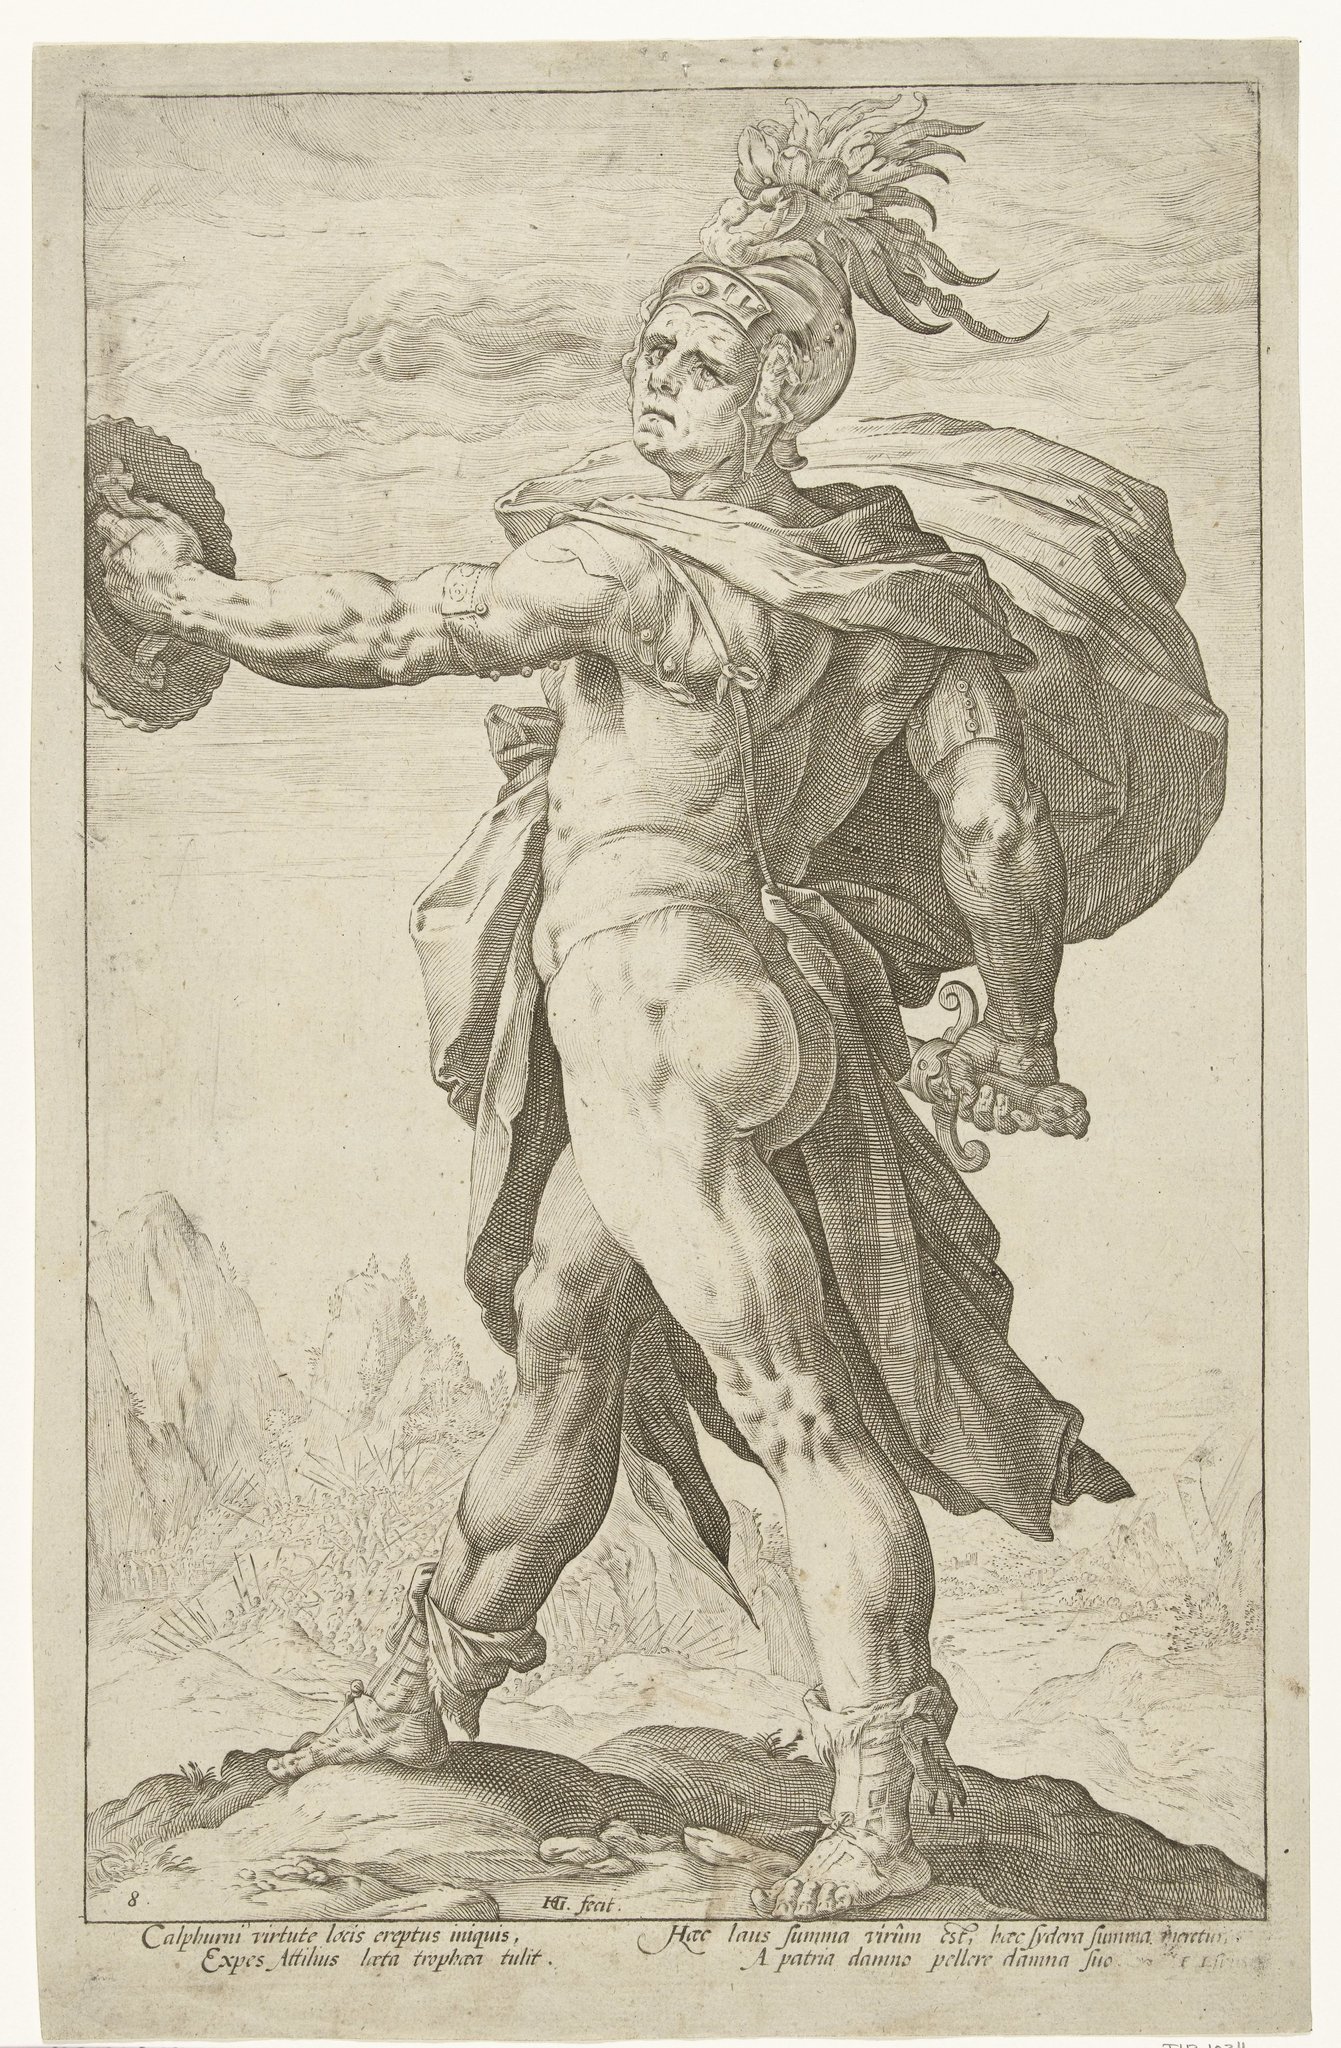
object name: print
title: Calpurnius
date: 1586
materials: paper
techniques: engraving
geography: haarlem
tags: male persons from classical history (calpurnius, m.)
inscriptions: collector's mark: Lugt 2228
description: De held Marcus Calpurnius Flama ten voeten uit, op de linkerzijde gezien. Op de achtergrond is te zien hoe hij met een klein leger consul Attilius Calatinus redde uit een hinderlaag. Onder de voorstelling twee maal twee versregels in Latijn.